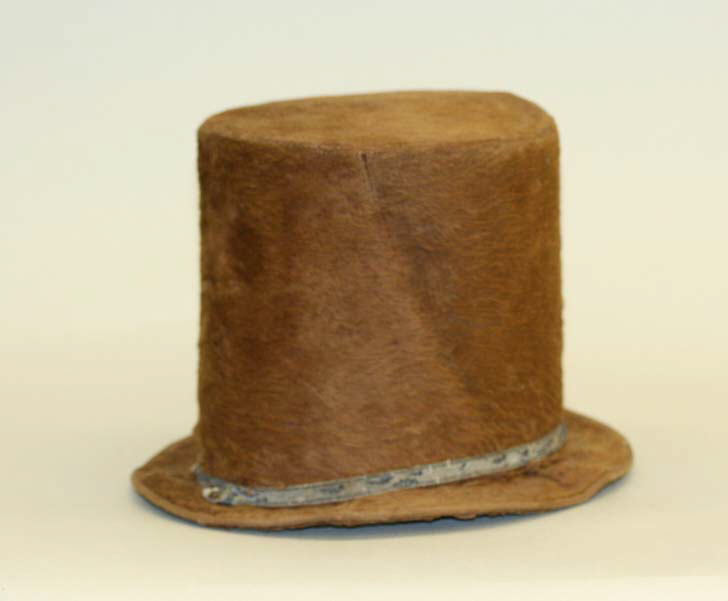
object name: top hat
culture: american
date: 1830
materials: silk